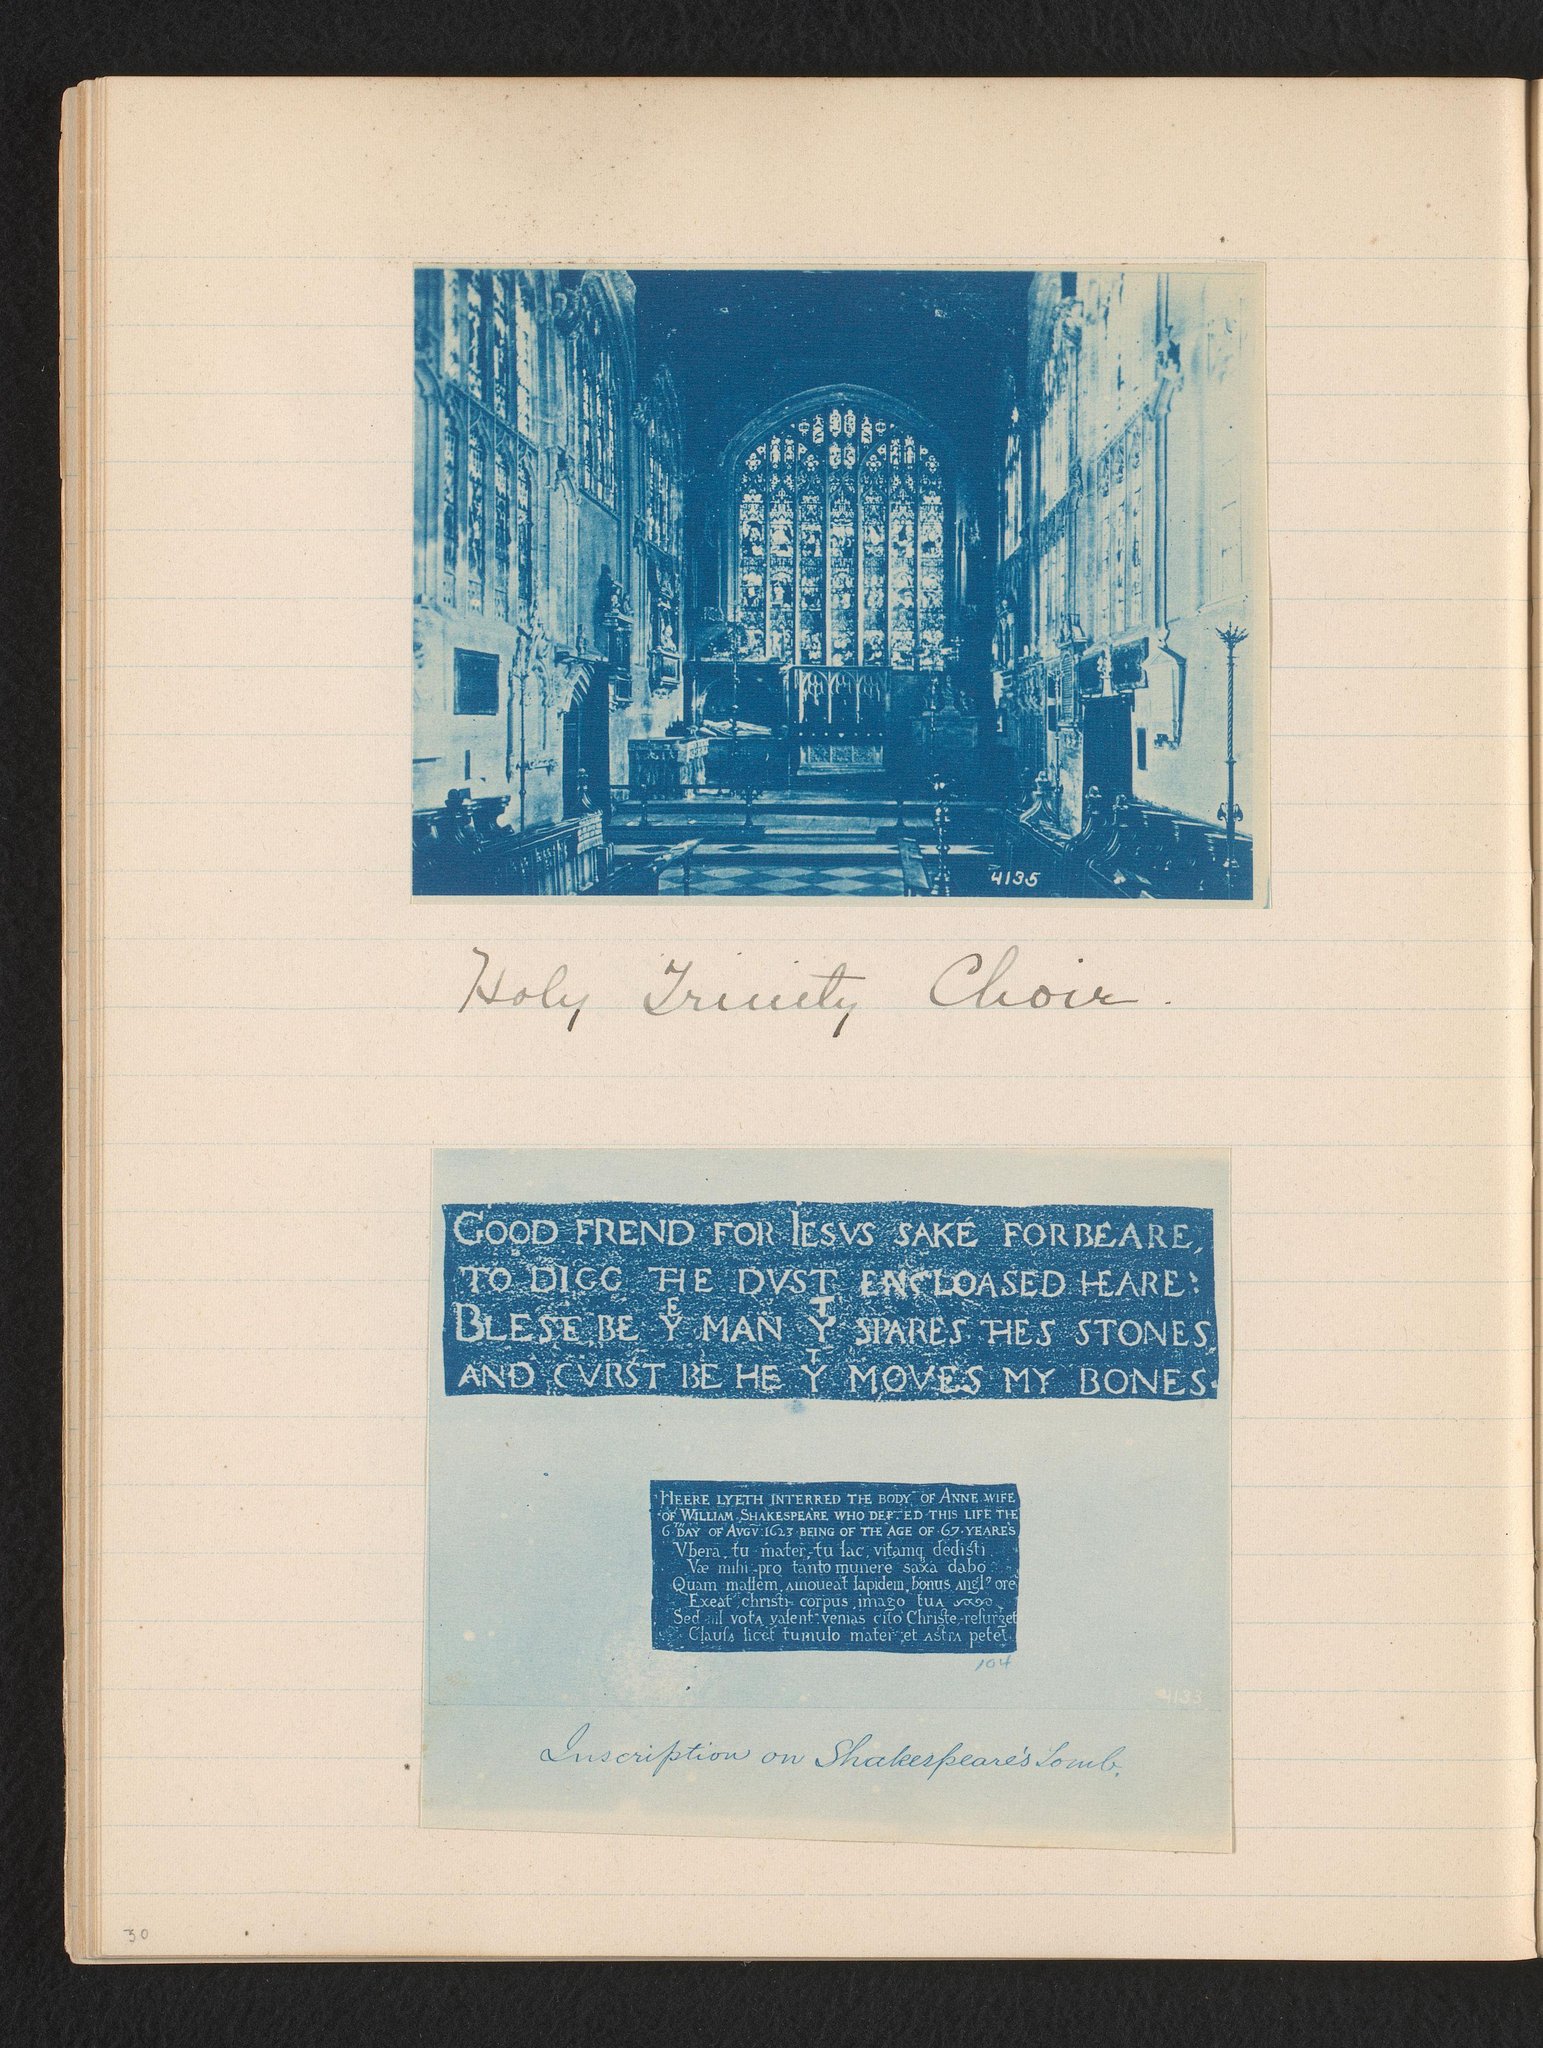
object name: photograph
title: Twee foto's van het interieur en een inscriptie in Holy Trinity Church in Stratford-upon-Avon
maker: Anonymous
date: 1901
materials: paper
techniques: cyanotype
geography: stratford-upon-avon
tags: inscription, interior of church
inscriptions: inscription: ‘Holy Trinity Choir’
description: Deze foto's maken deel uit van een album.